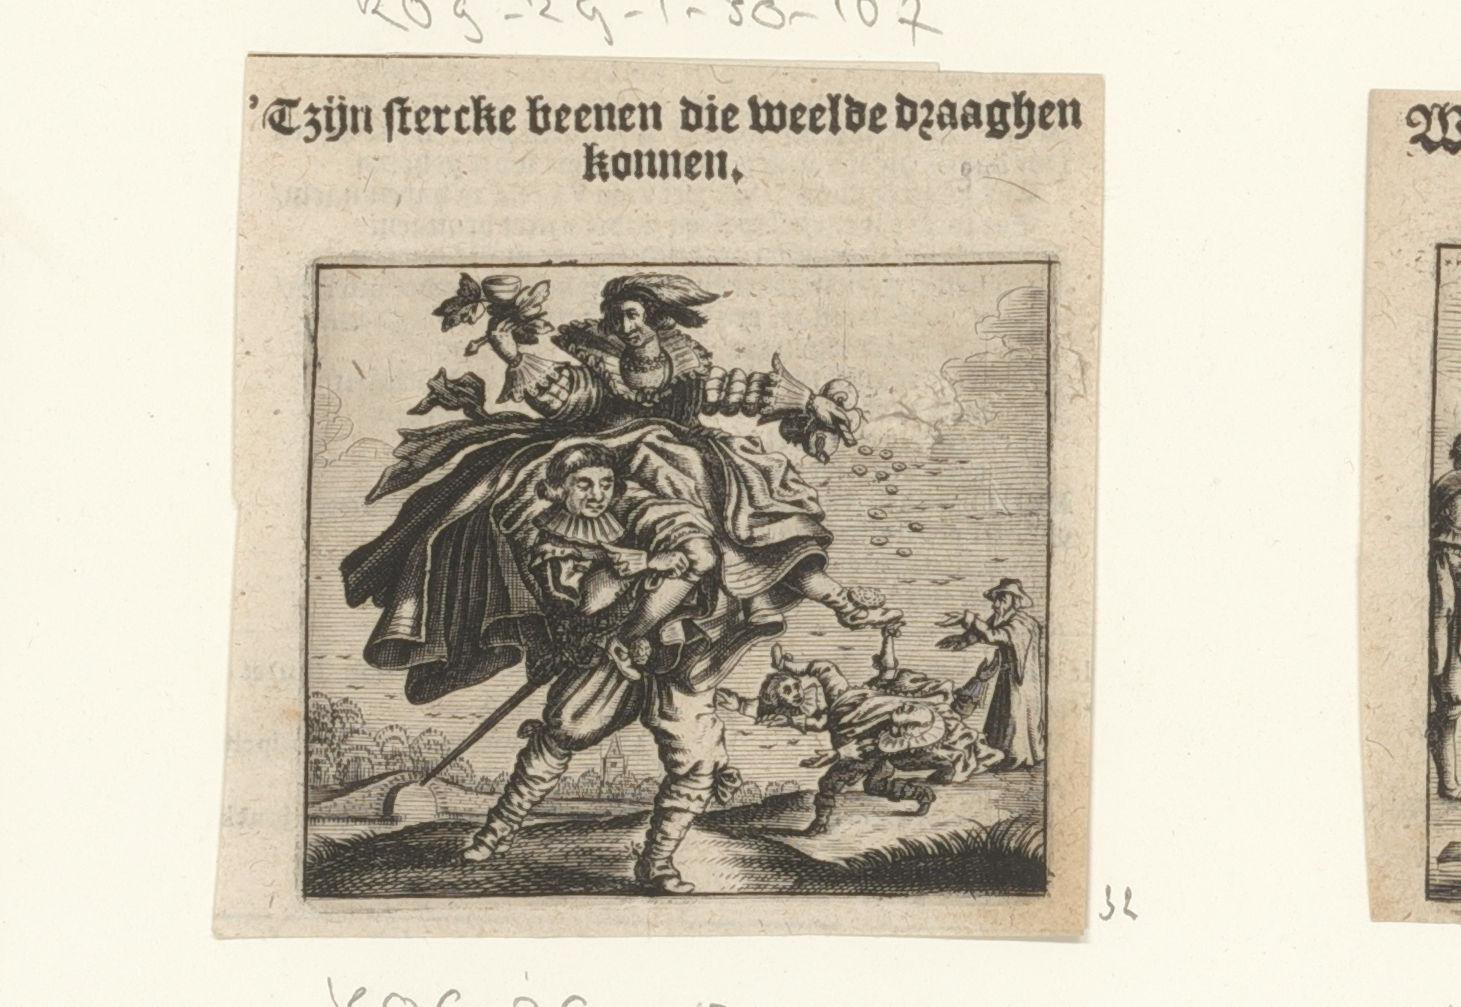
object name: book illustration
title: 'T zijn stercke beenen die weelde draaghen konnen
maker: Anonymous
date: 1635-1715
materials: paper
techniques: engraving, letterpress printing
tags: proverbs, sayings, etc., exhibition of wealth, money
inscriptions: collector's mark: Lugt 1641, stamp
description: Veel versies van dit embleem verschenen in verschillende uitgave van Spiegel van den Ouden ende Nieuwen Tydt. Zoals: Cats, Jacob. Spiegel van den Ouden ende Nieuwen-tijt, Bestaende uyt Spreeck-woorden (...). Dordrecht: Jacob Braat, 1647. Maar ook in andere publicaties (1665, 1671, 1715, 1722).